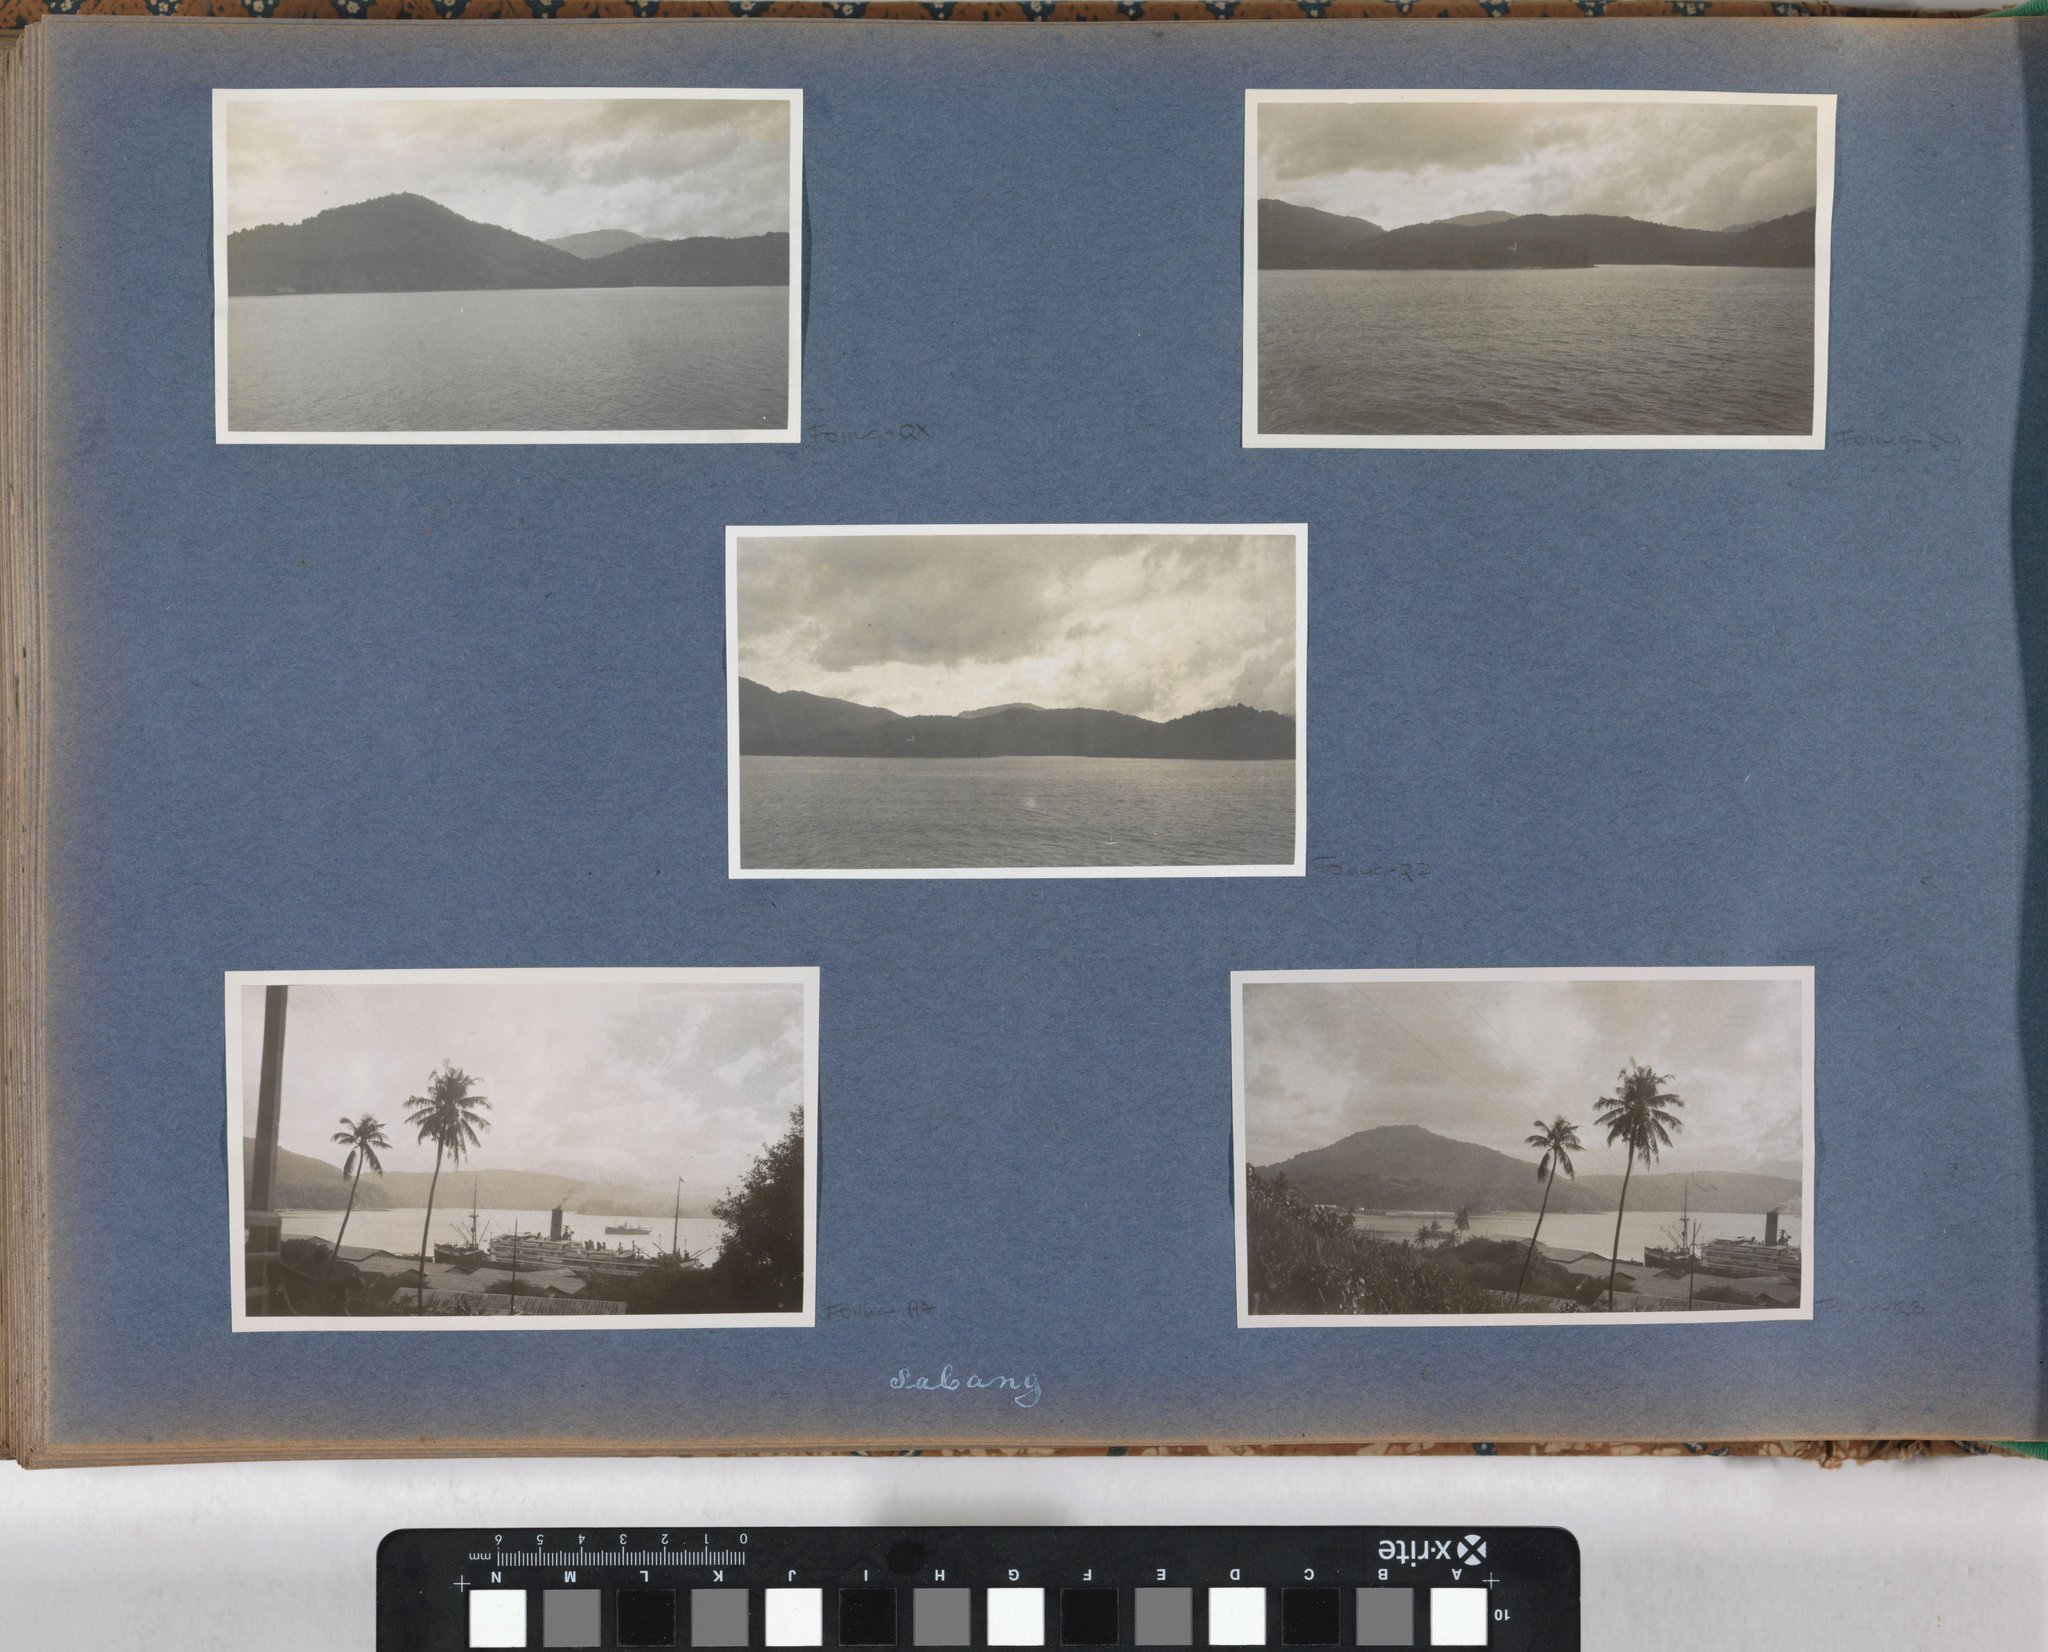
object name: album leaf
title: Meer met bergen bij Sabang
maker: Anonymous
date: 1900-1920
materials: paper, photographic support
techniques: gelatin silver print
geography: sabang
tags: lake, mountains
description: Onderdeel van reisalbum met foto's van bedrijvigheid en bezienswaardigheden op Sumatra en Java en van de reis naar en van Nederlands-Indië.